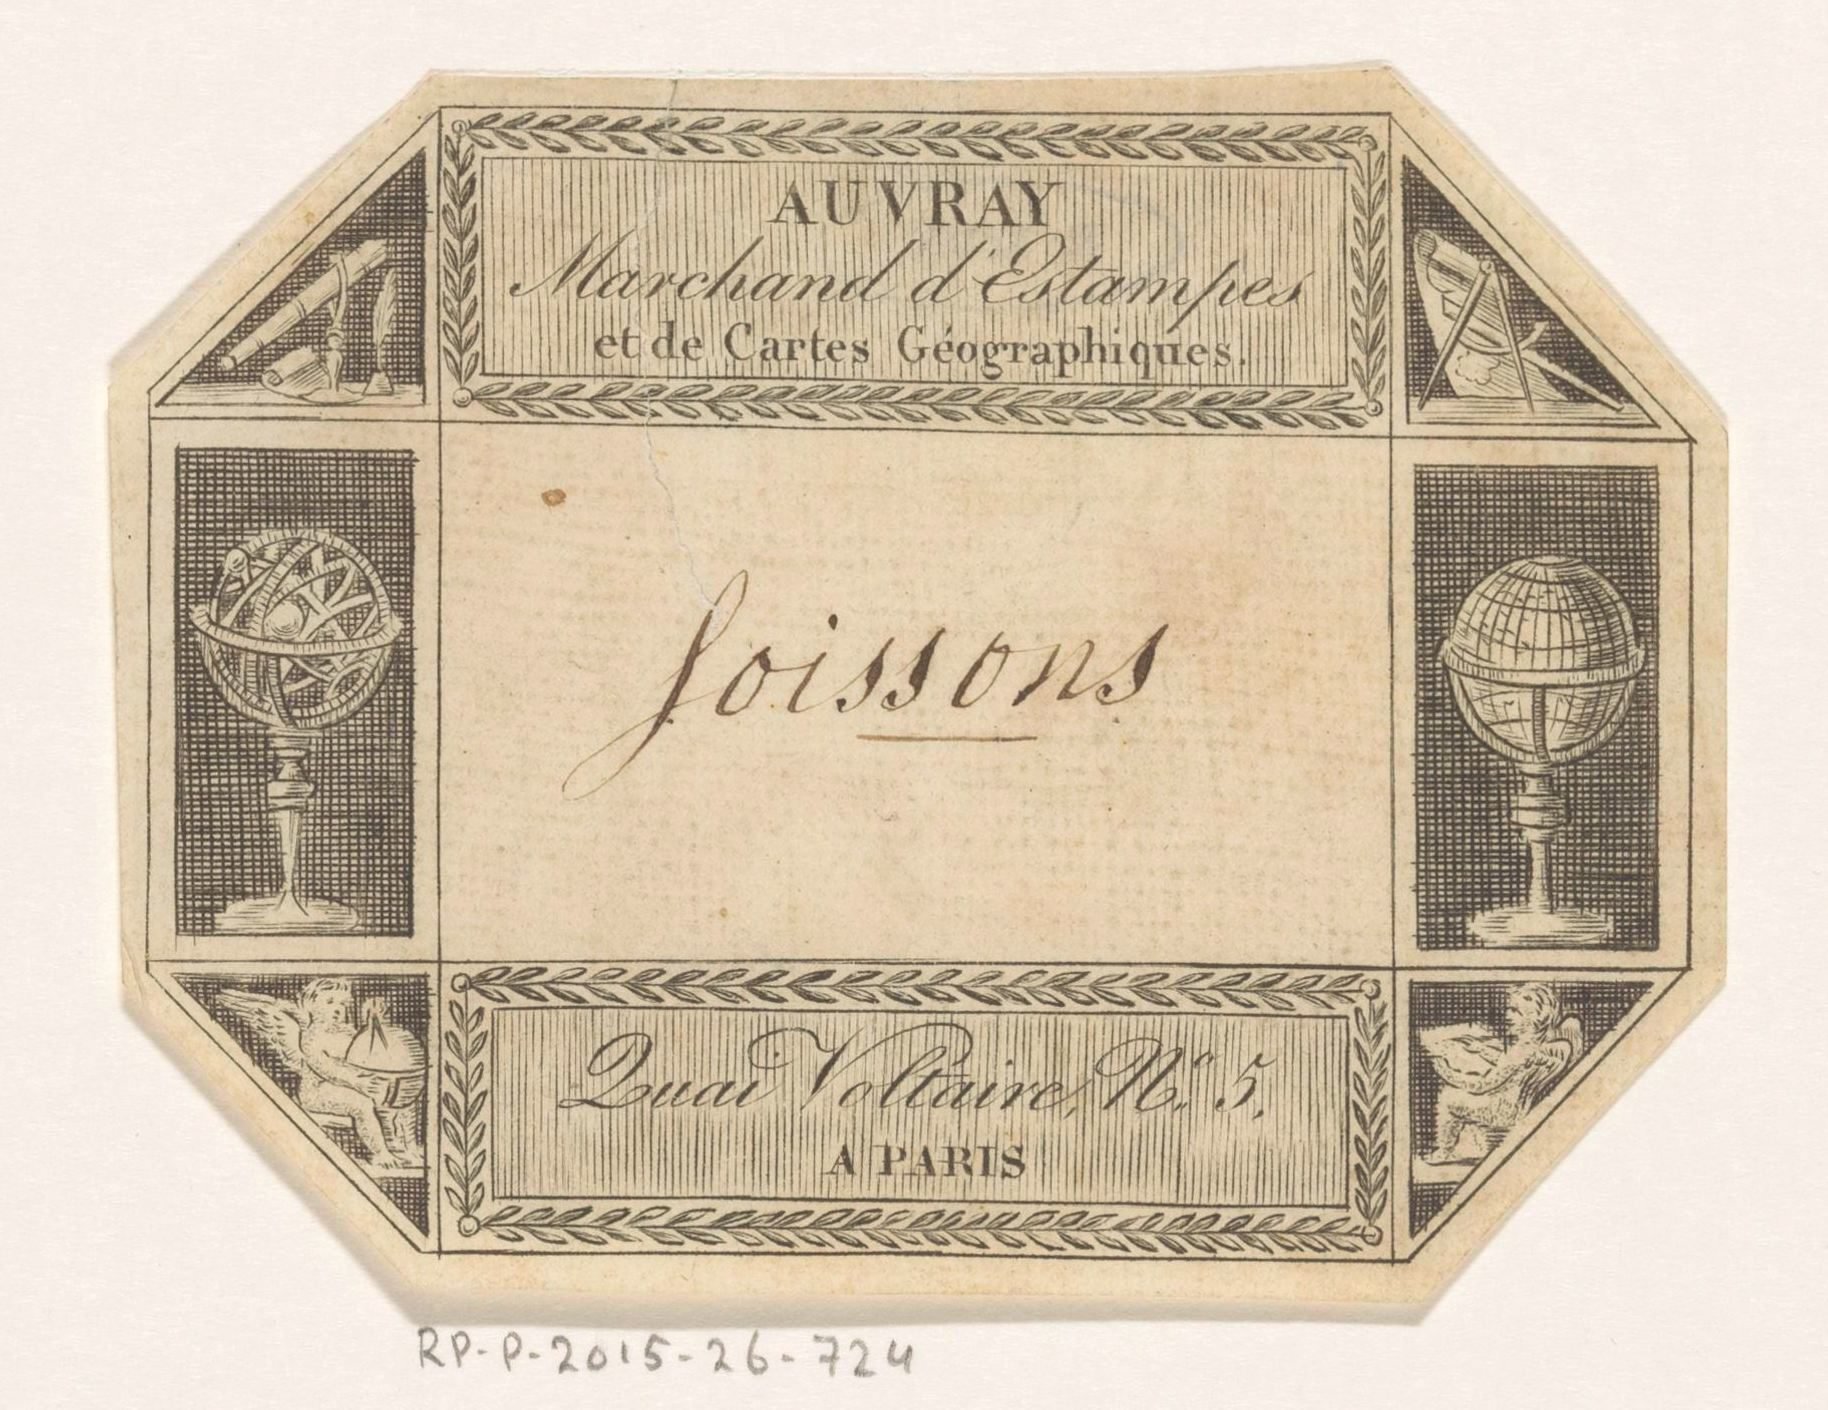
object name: print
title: Etiket van prenthandel Auvray te Parijs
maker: Anonymous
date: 1775-1825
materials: paper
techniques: engraving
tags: armillary sphere, skeleton celestial globe, map making, globe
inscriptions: inscription: ‘Soissons’, collector's mark: Lugt 2228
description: Een wereldbol en een hemelglobe, een passer met een kaart en een telescoop verwijzen naar de specialisatie van de prenthandel: de cartografie.